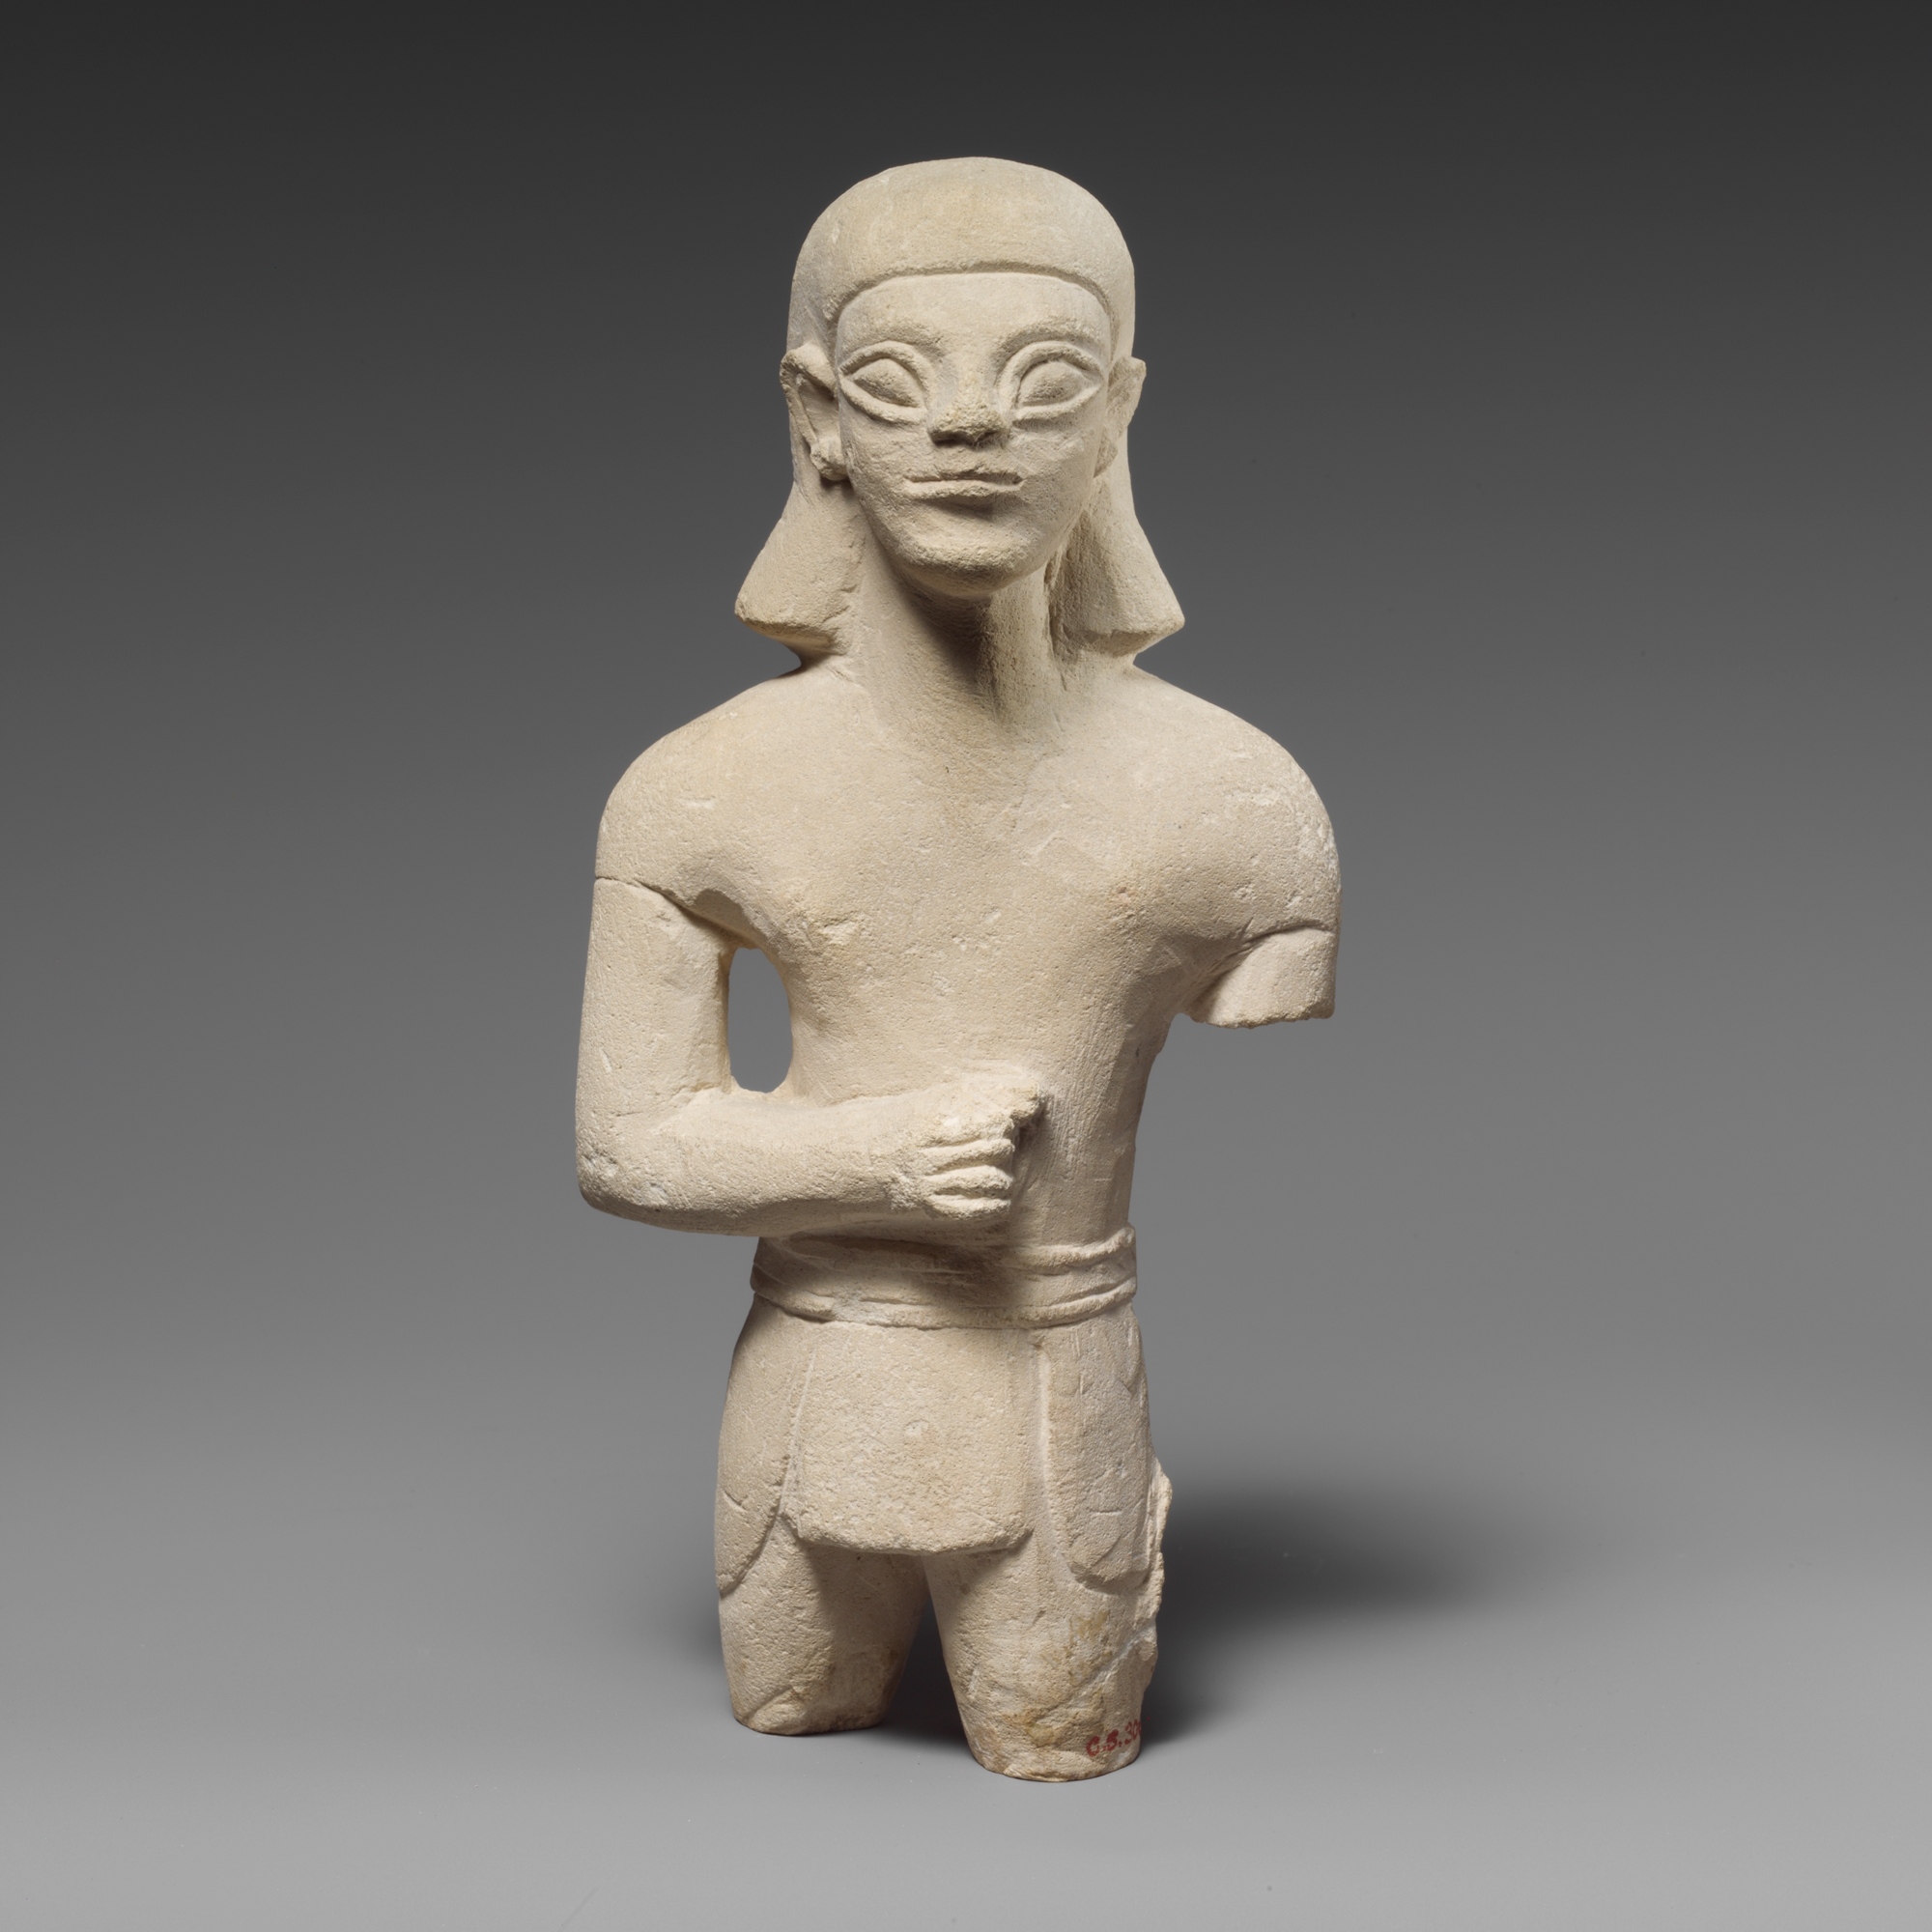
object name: statuette of a man in egyptian dress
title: Limestone statuette of a beardless male votary in Egyptianizing dress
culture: cypriot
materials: limestone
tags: men